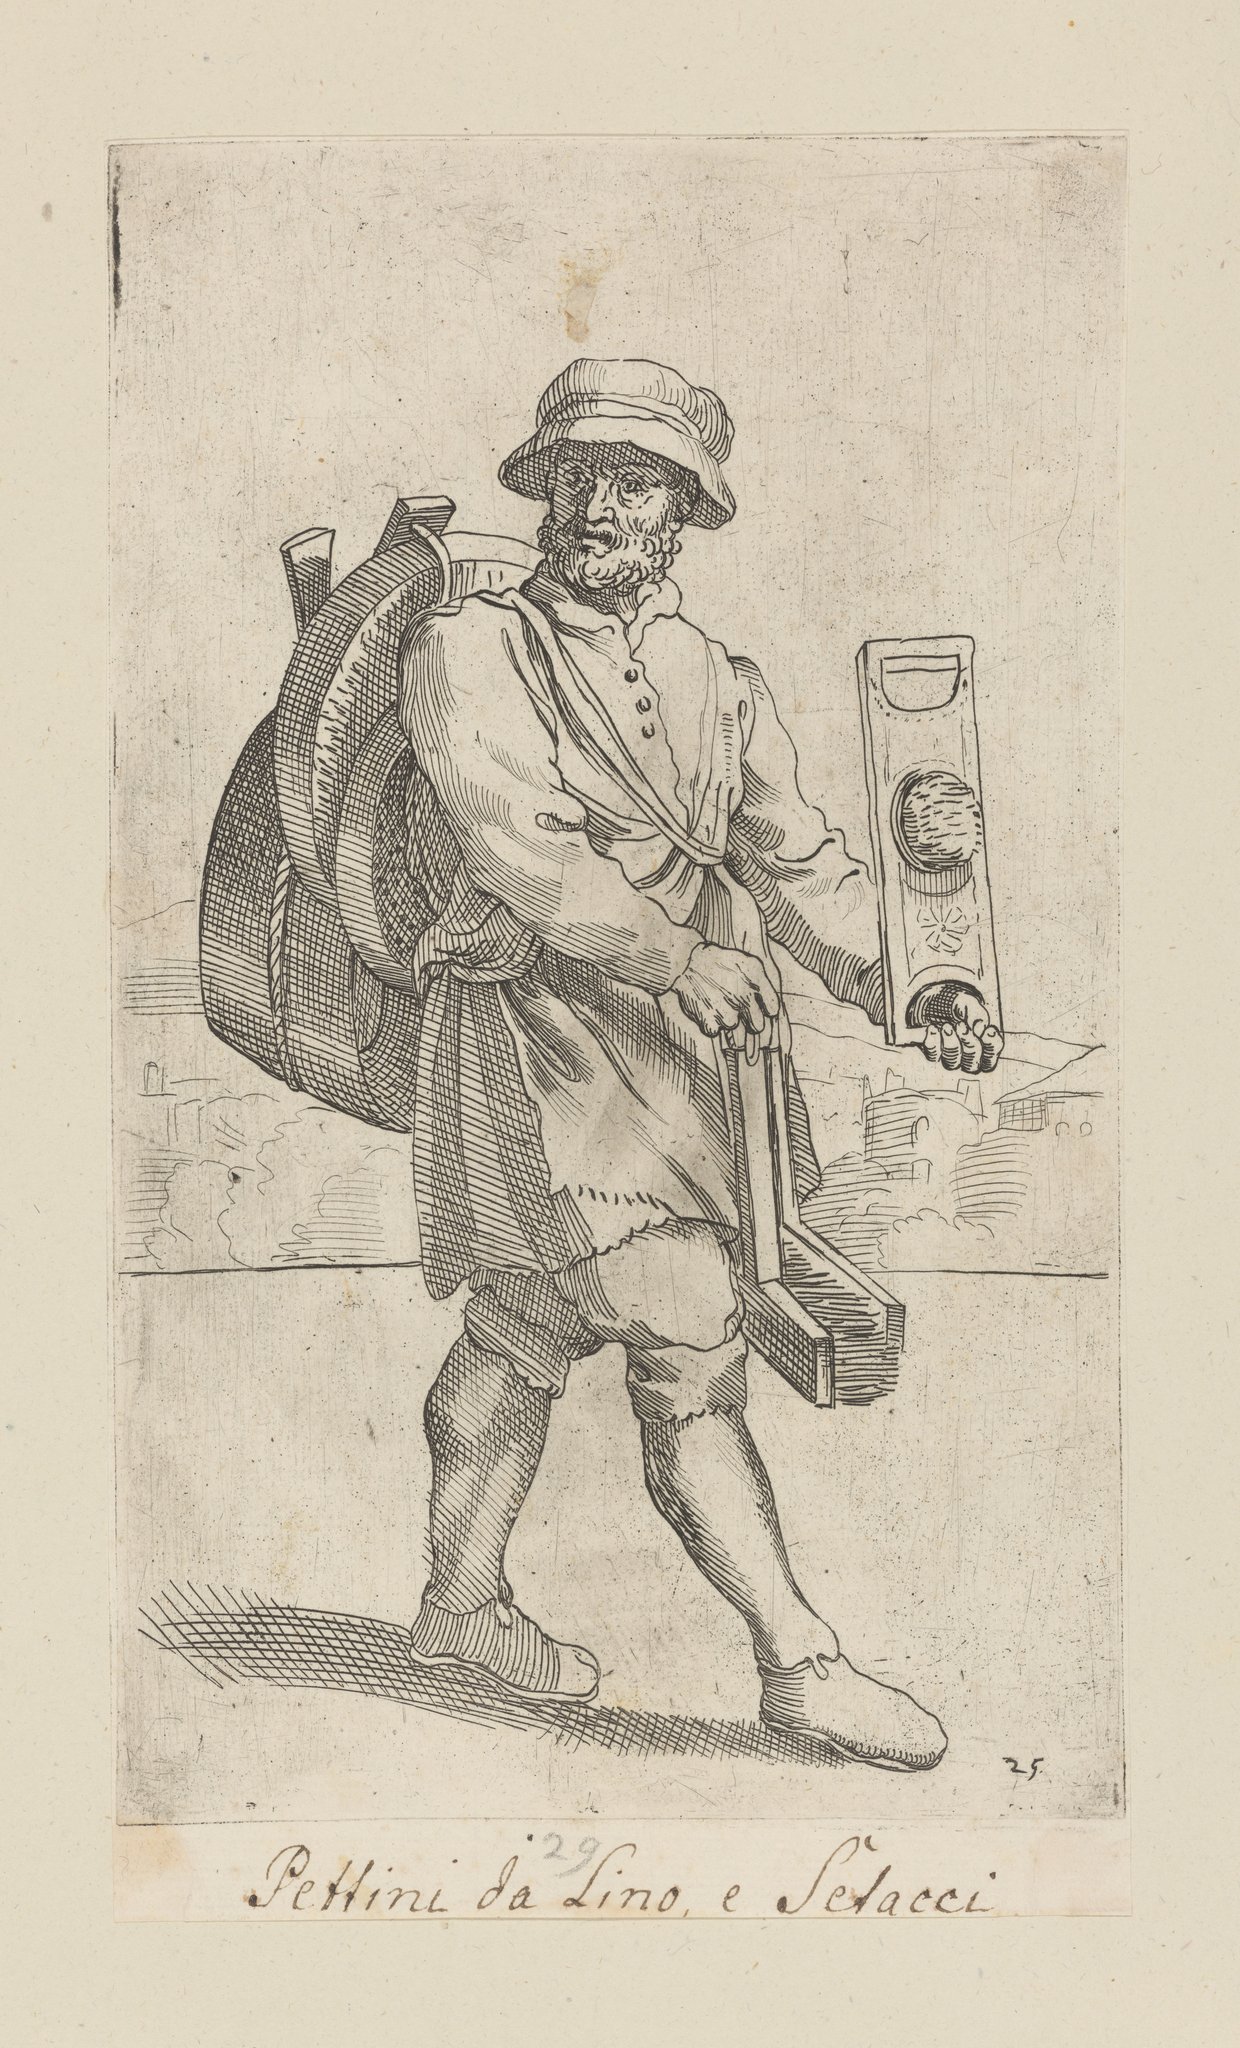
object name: print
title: Plate 25: linen and silk carder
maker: simon guillain ii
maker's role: artist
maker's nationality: french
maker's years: 1618-1718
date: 1646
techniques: etching